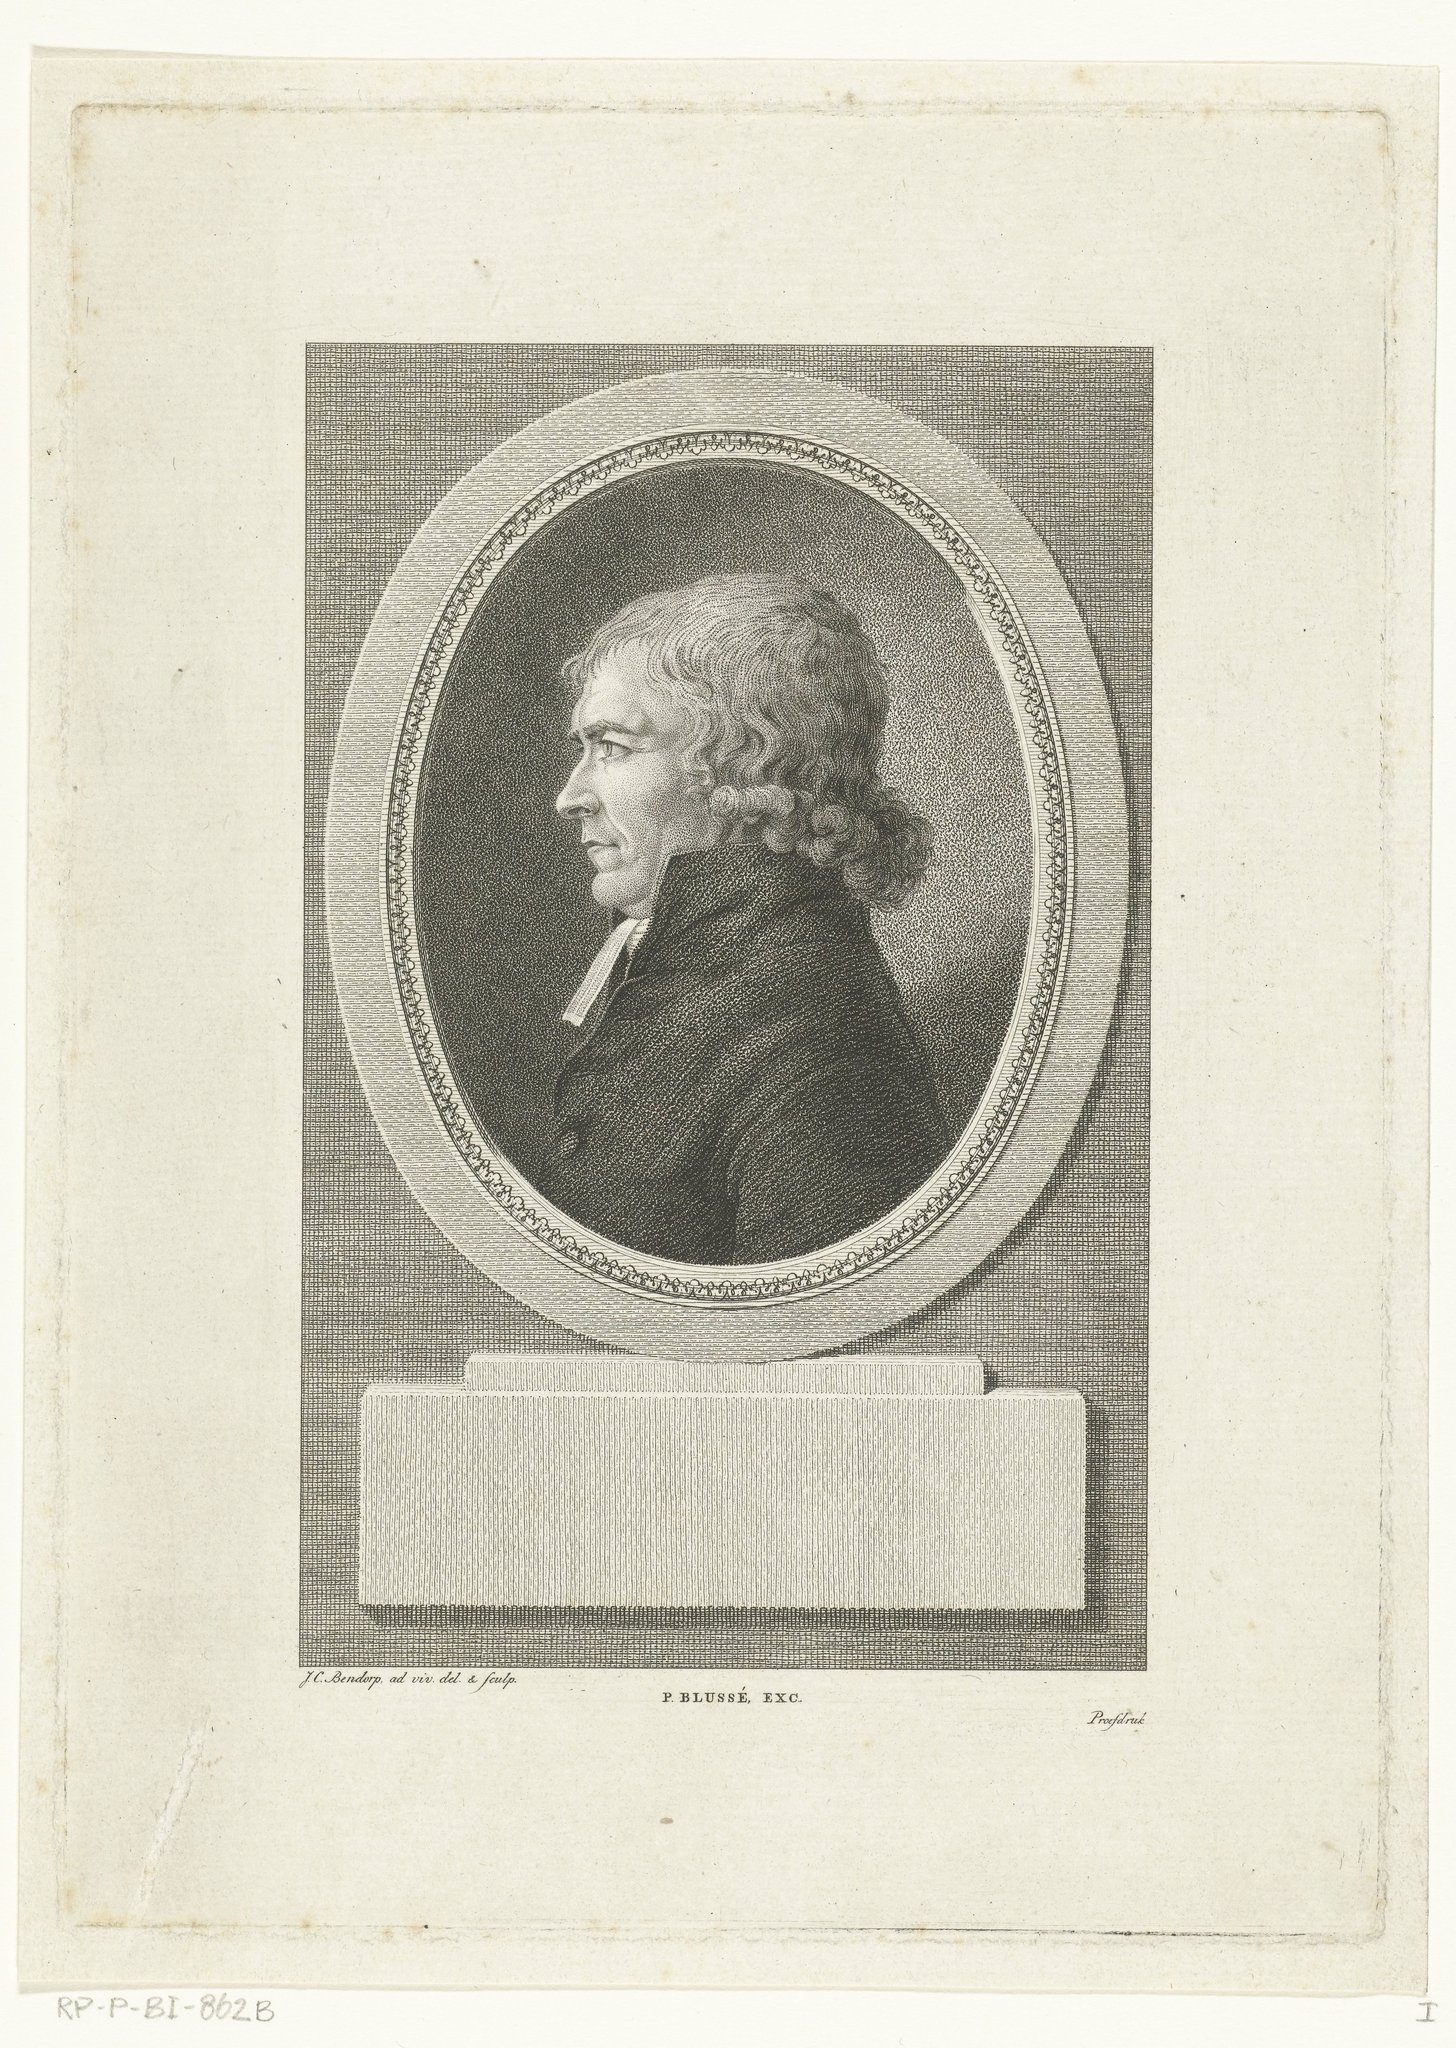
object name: print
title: Portret van predikant Willem Christiaan van Manen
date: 1808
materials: paper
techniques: etching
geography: netherlands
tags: functionaries and dignitaries (with name) ~ episcopal protestant churches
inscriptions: collector's mark: Lugt 2228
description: Buste van predikant Willem Christiaan van Manen in ovale omlijsting met onder voorstelling leeg cartouche voor lofdicht.